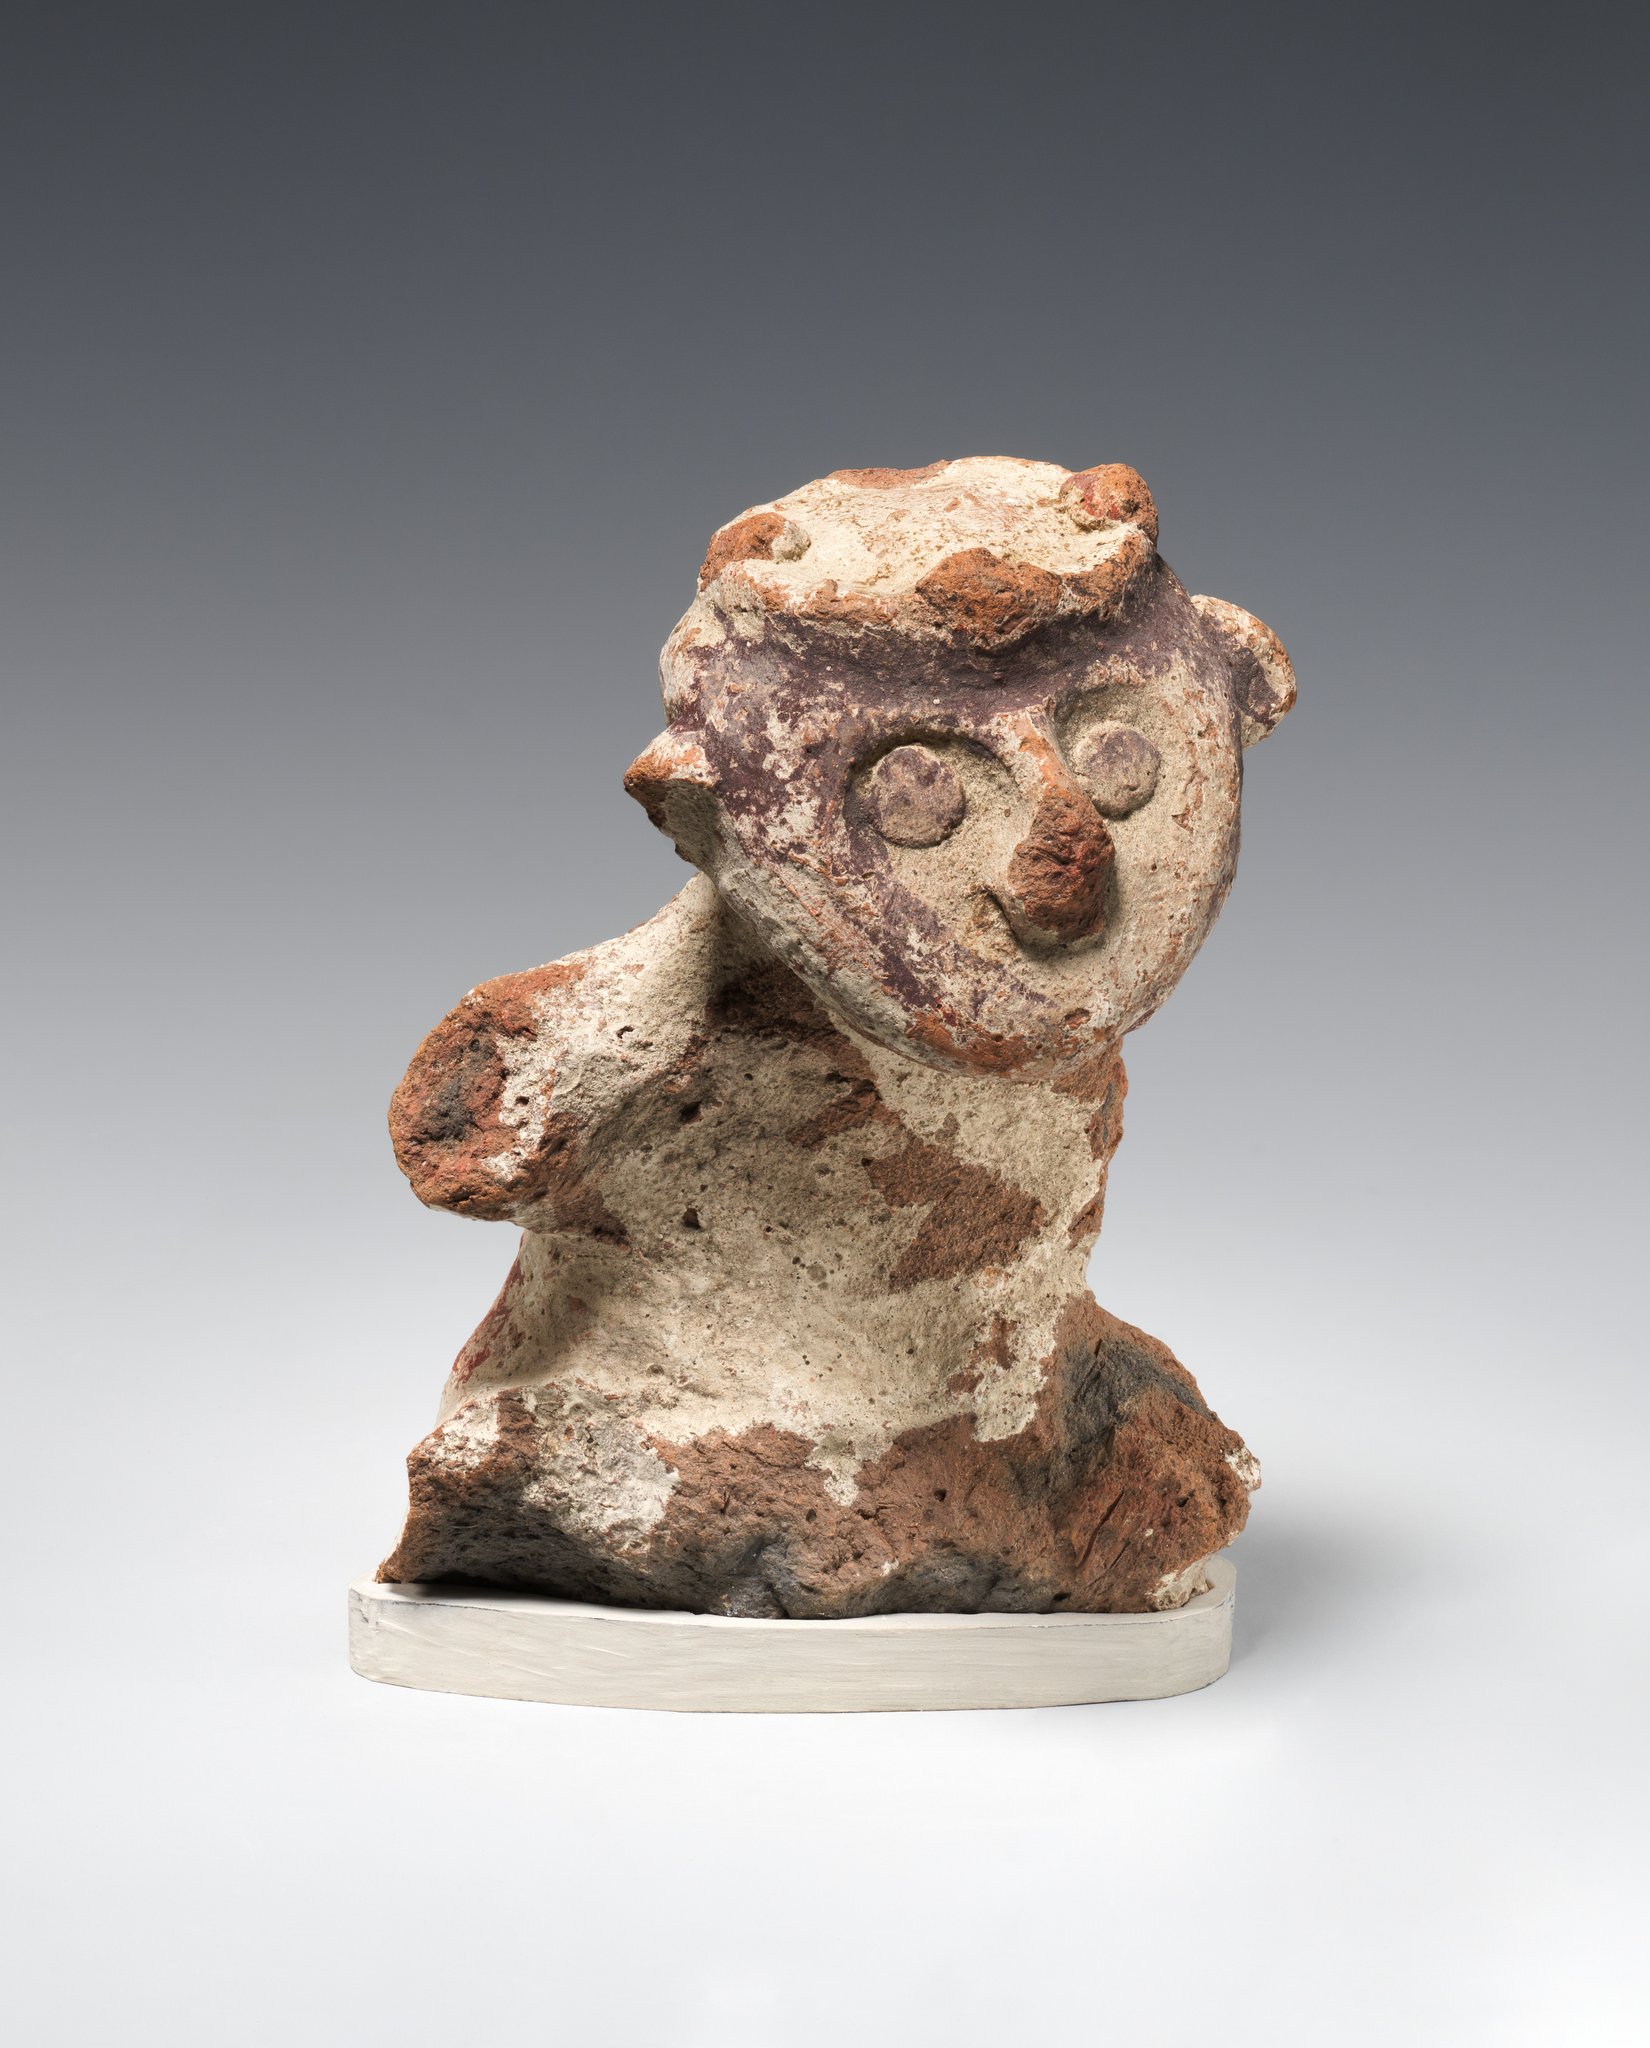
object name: figurine fragment, human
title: Human Figure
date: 306-30 BCE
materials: paint, pottery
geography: egypt